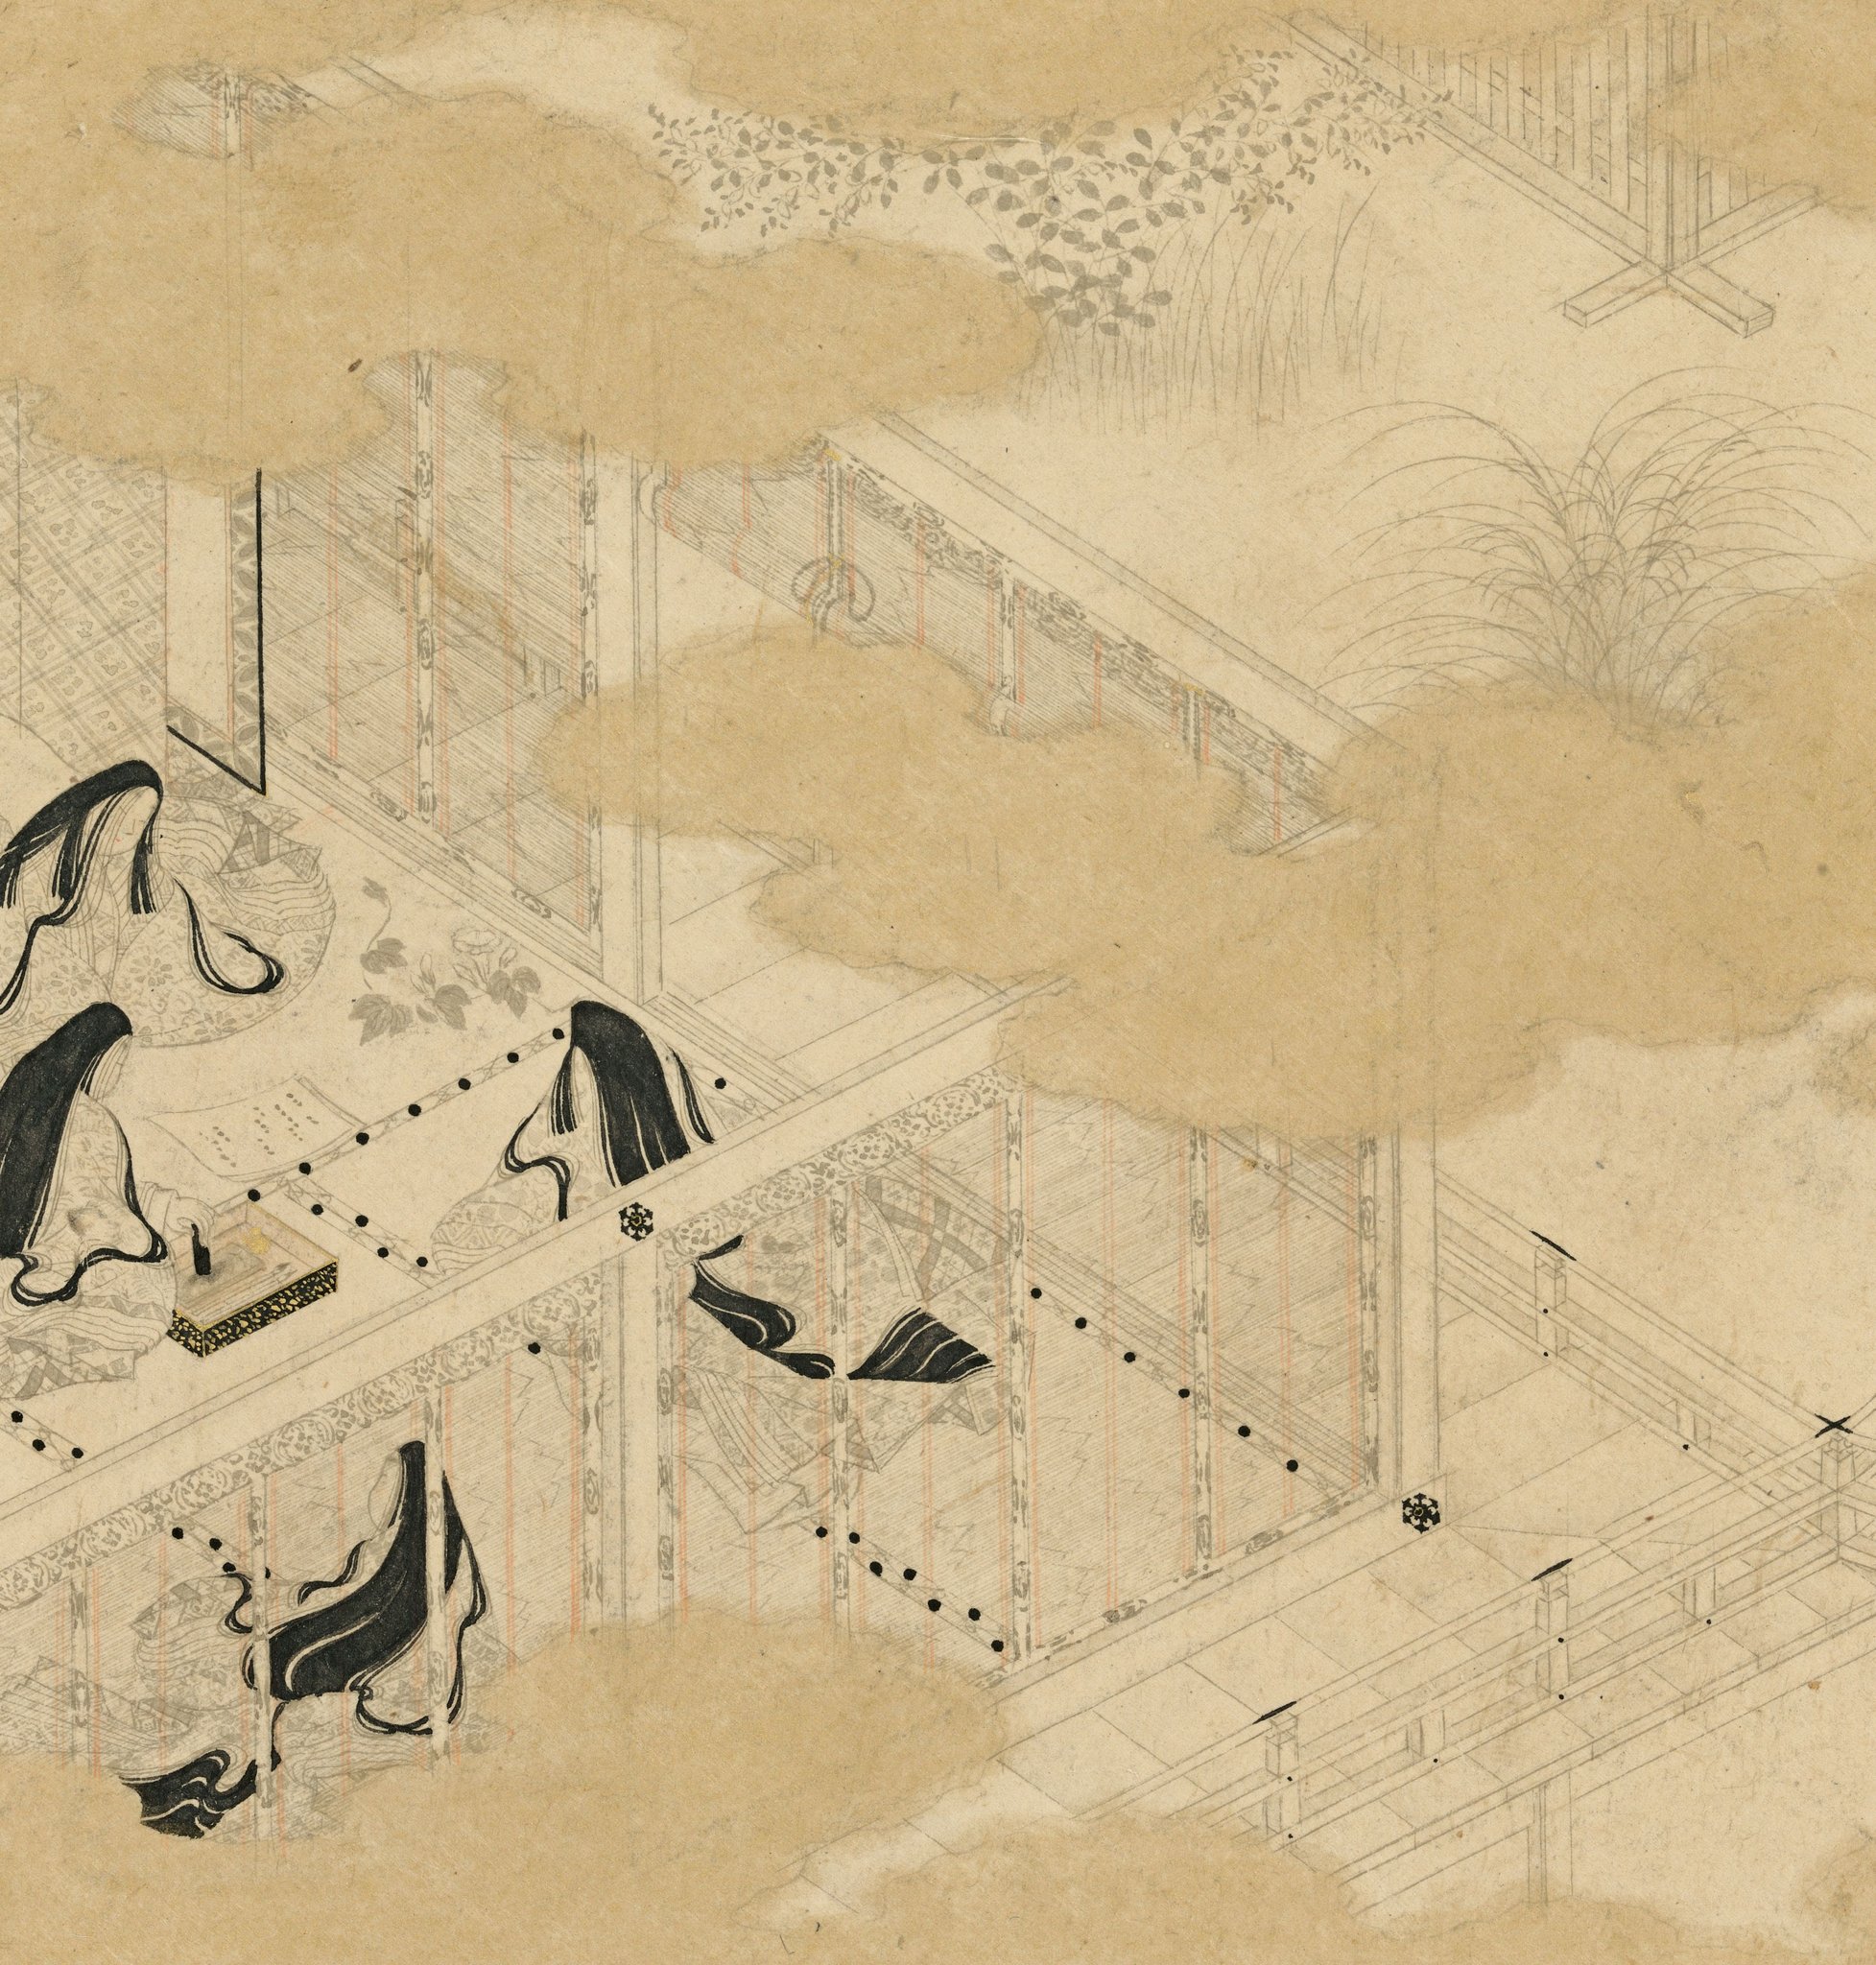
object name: album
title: Albums of scenes from The Tale of Genji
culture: japanese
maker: tosa mitsunori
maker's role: artist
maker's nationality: japanese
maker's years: 1583-1638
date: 1601-1633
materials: gold, ink, paper, pigment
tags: men,women